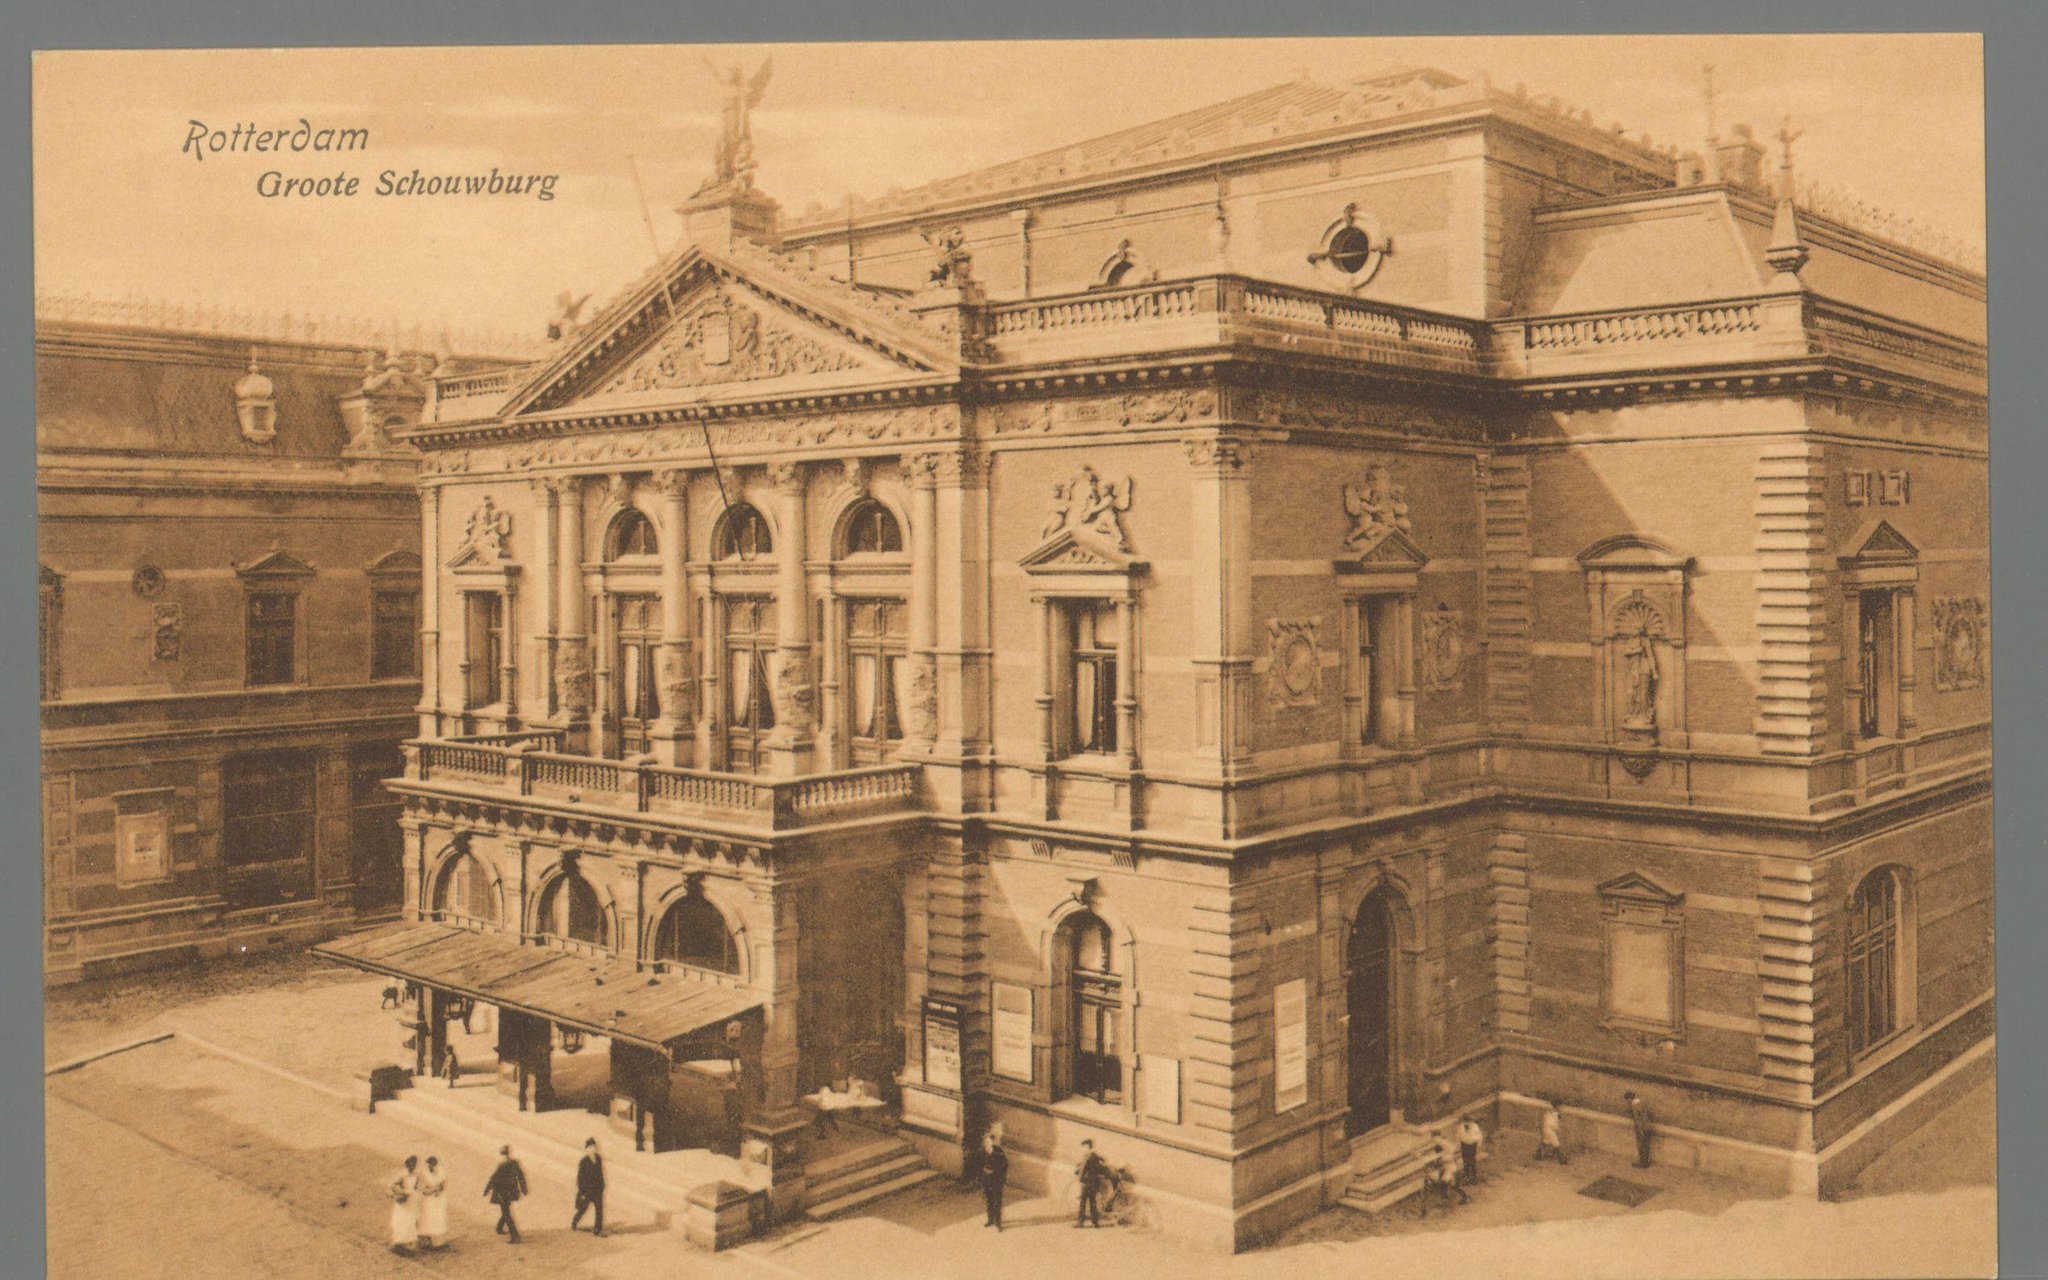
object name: photomechanical print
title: Rotterdam. Groote Schouwburg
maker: Anonymous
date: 1911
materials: cardboard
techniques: photograph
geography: the hague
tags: theatre (building)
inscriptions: date